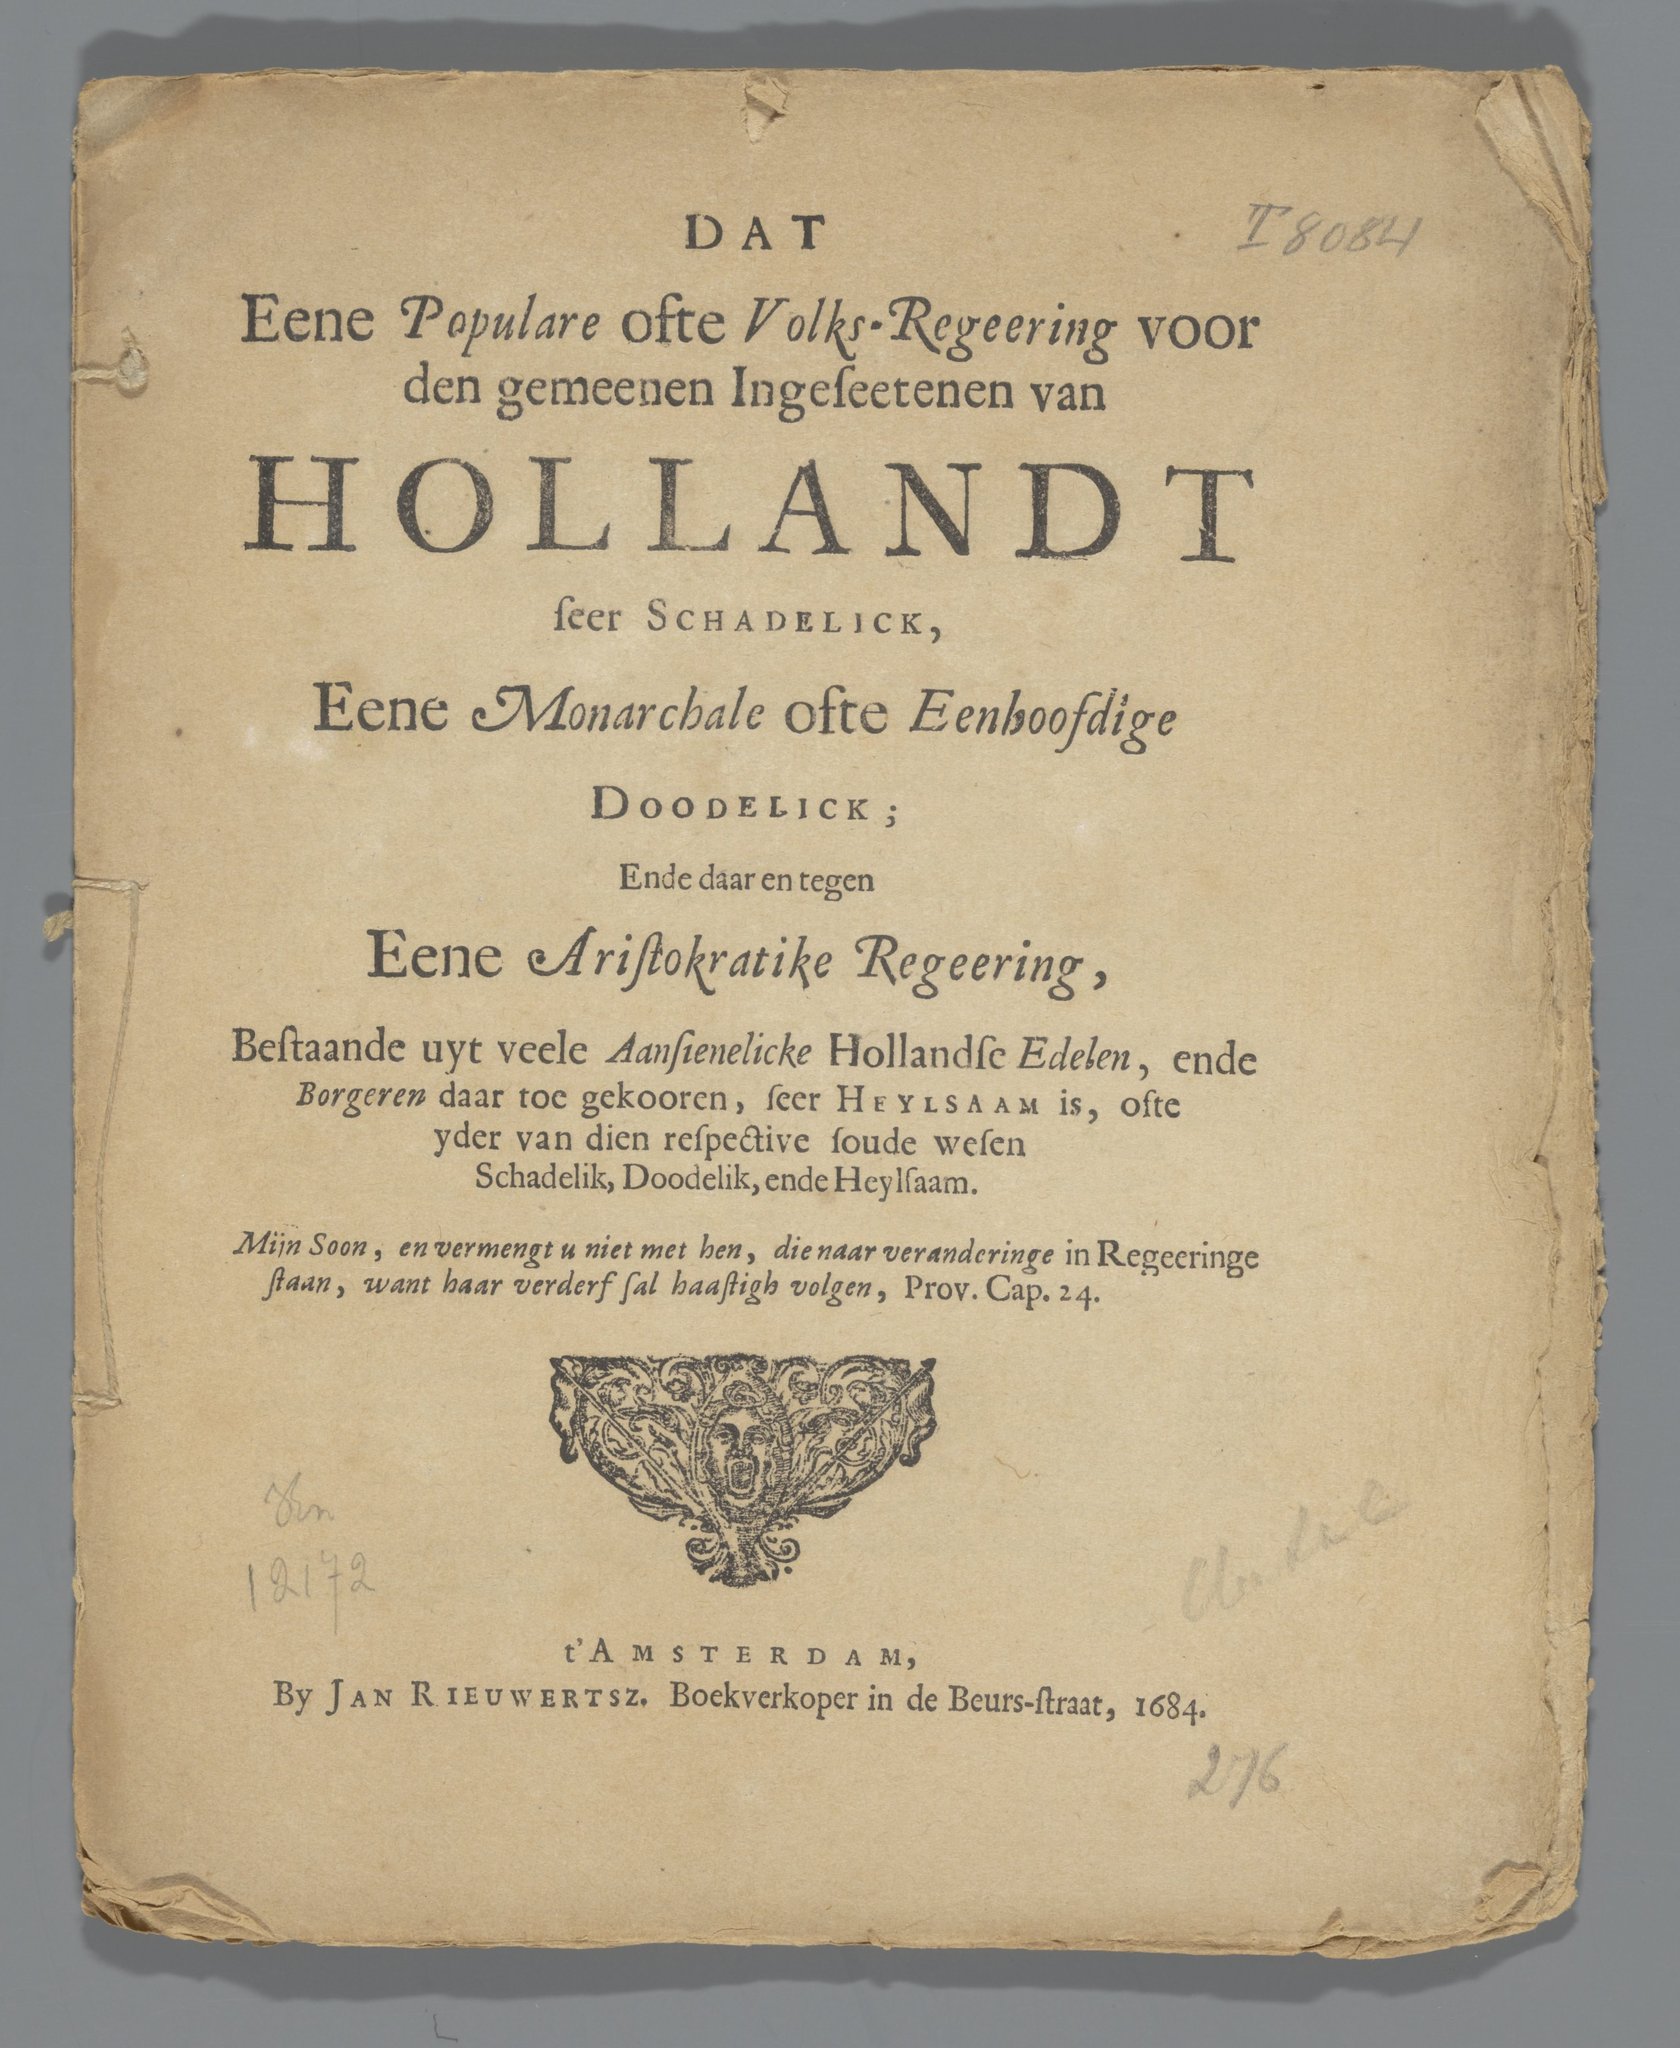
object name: brochure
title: Dat eene Populare ofte Volks-Regeering voor den gemeenen Ingeseetenen van Hollandt seer Schadelick, eene Monarchale (...) Doodelick; ende daarentegen eene Aristokratike (...)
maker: jan rieuwertsz. (i)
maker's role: printer, publisher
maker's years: 1616-1687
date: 1684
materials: paper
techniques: printing, sewing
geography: amsterdam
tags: netherlands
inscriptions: date